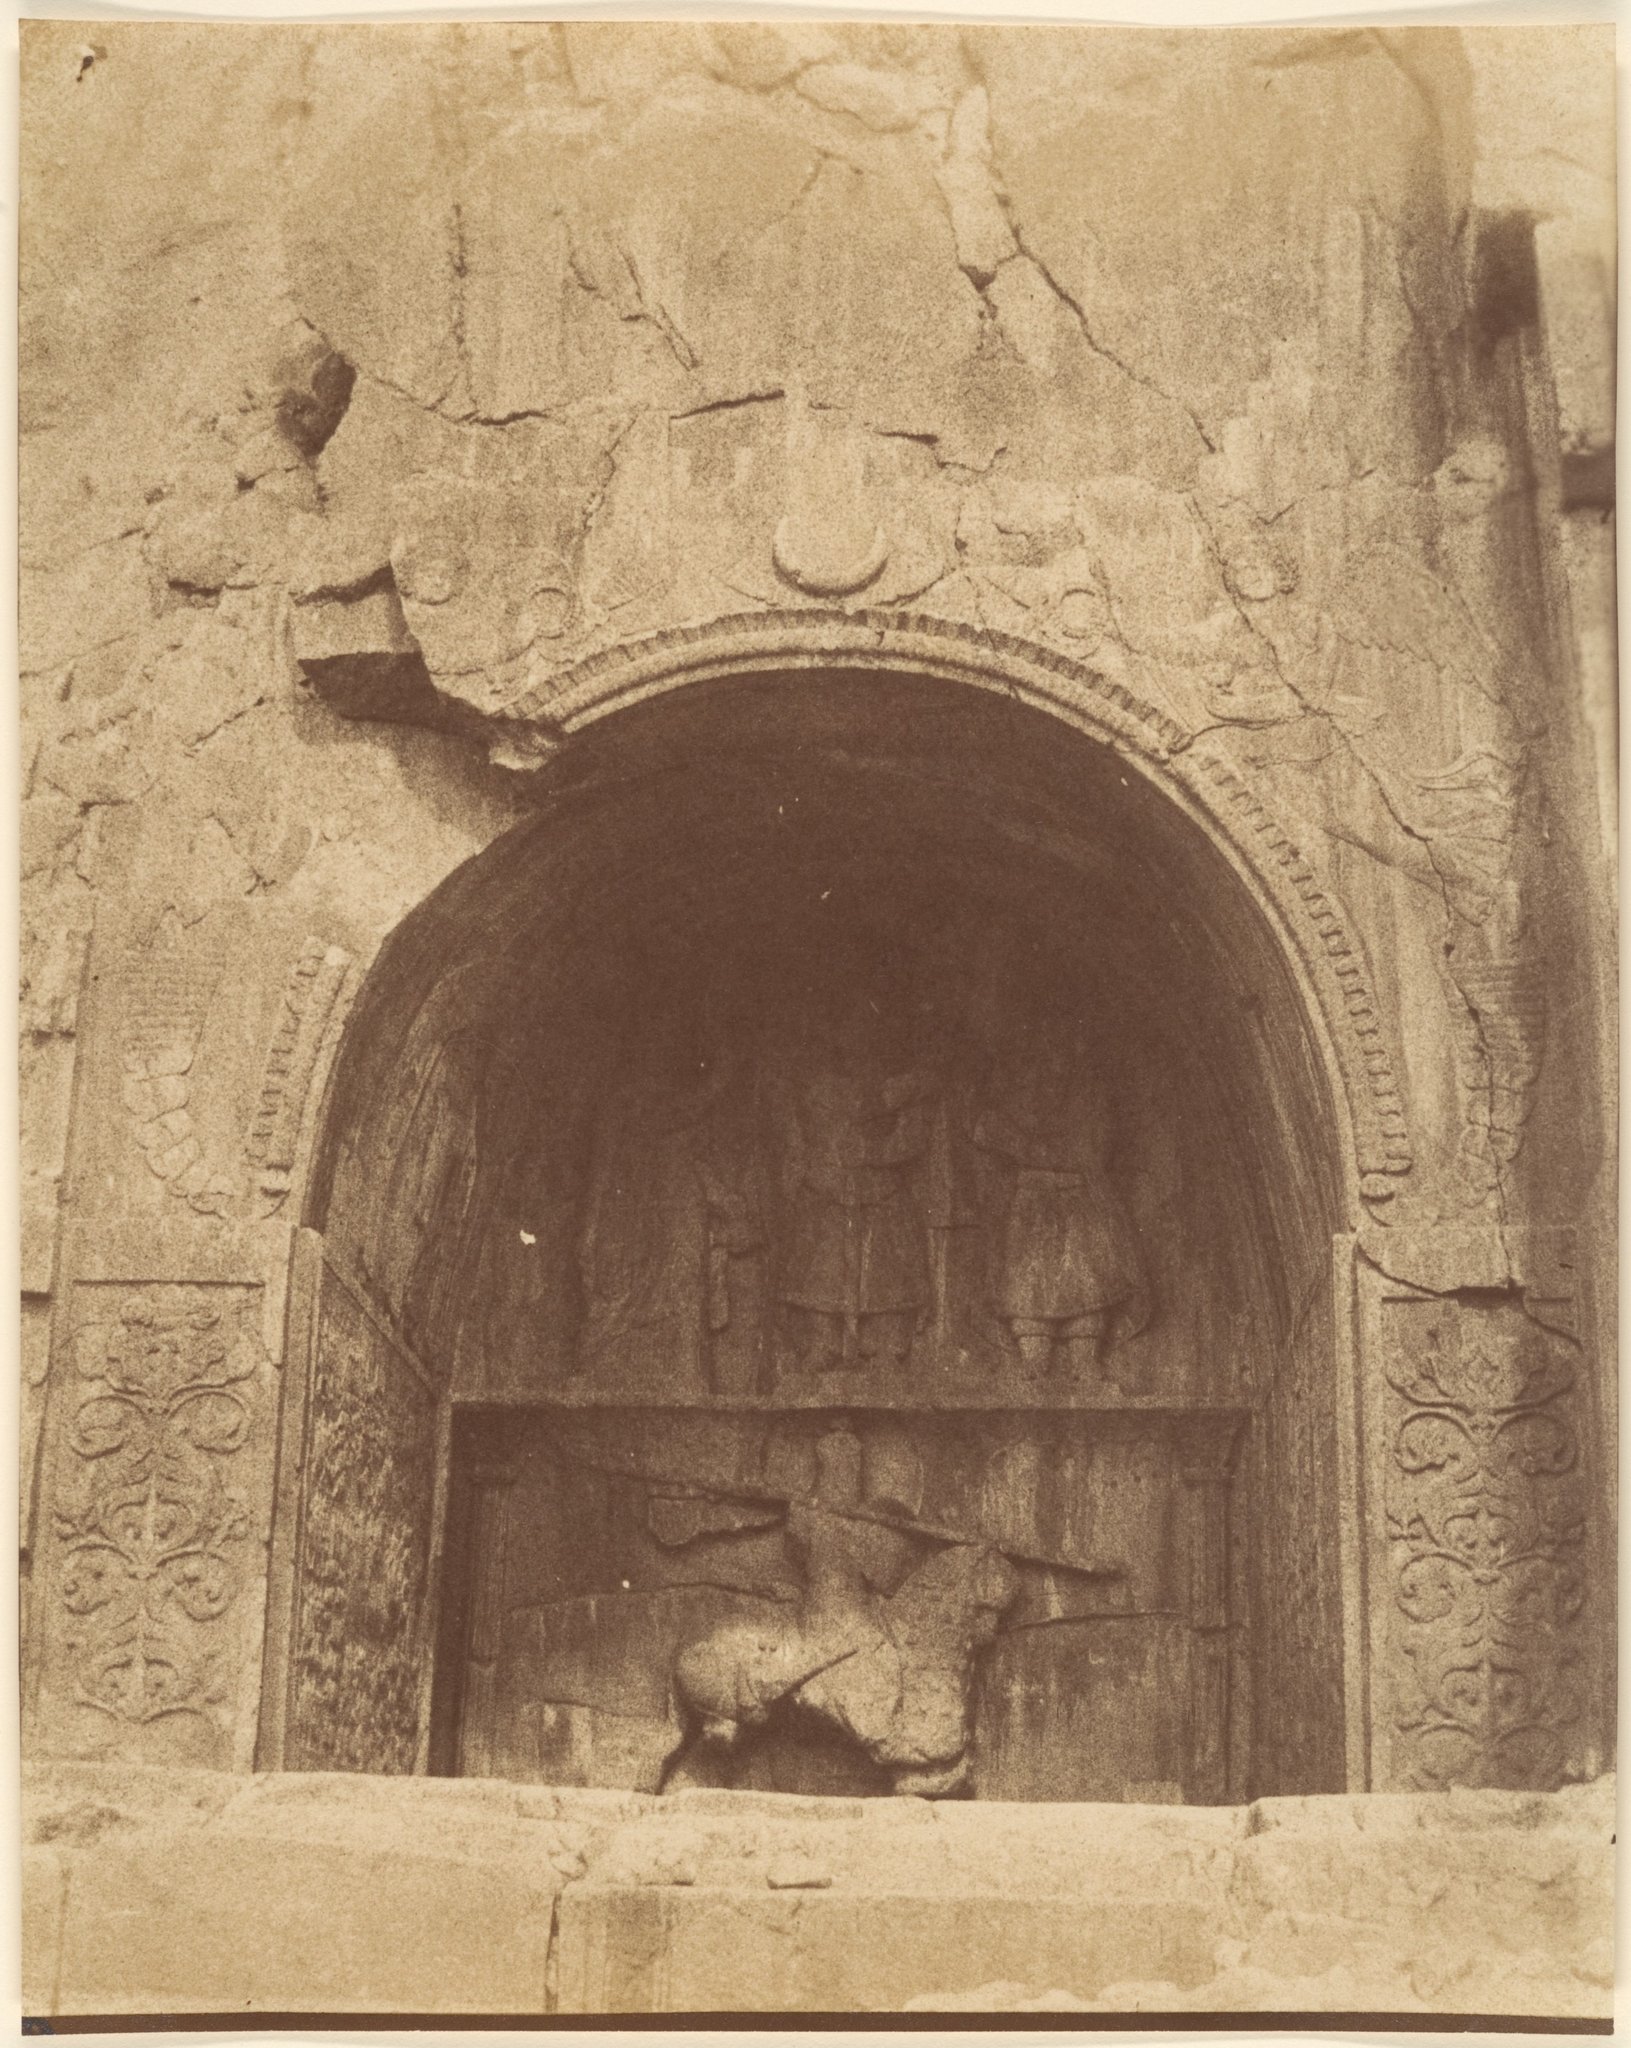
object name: photograph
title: [Tag-e bustan, Kermanshah, Kurdestan]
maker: luigi pesce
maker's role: artist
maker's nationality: italian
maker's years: 1818-1891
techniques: albumen silver print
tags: arches